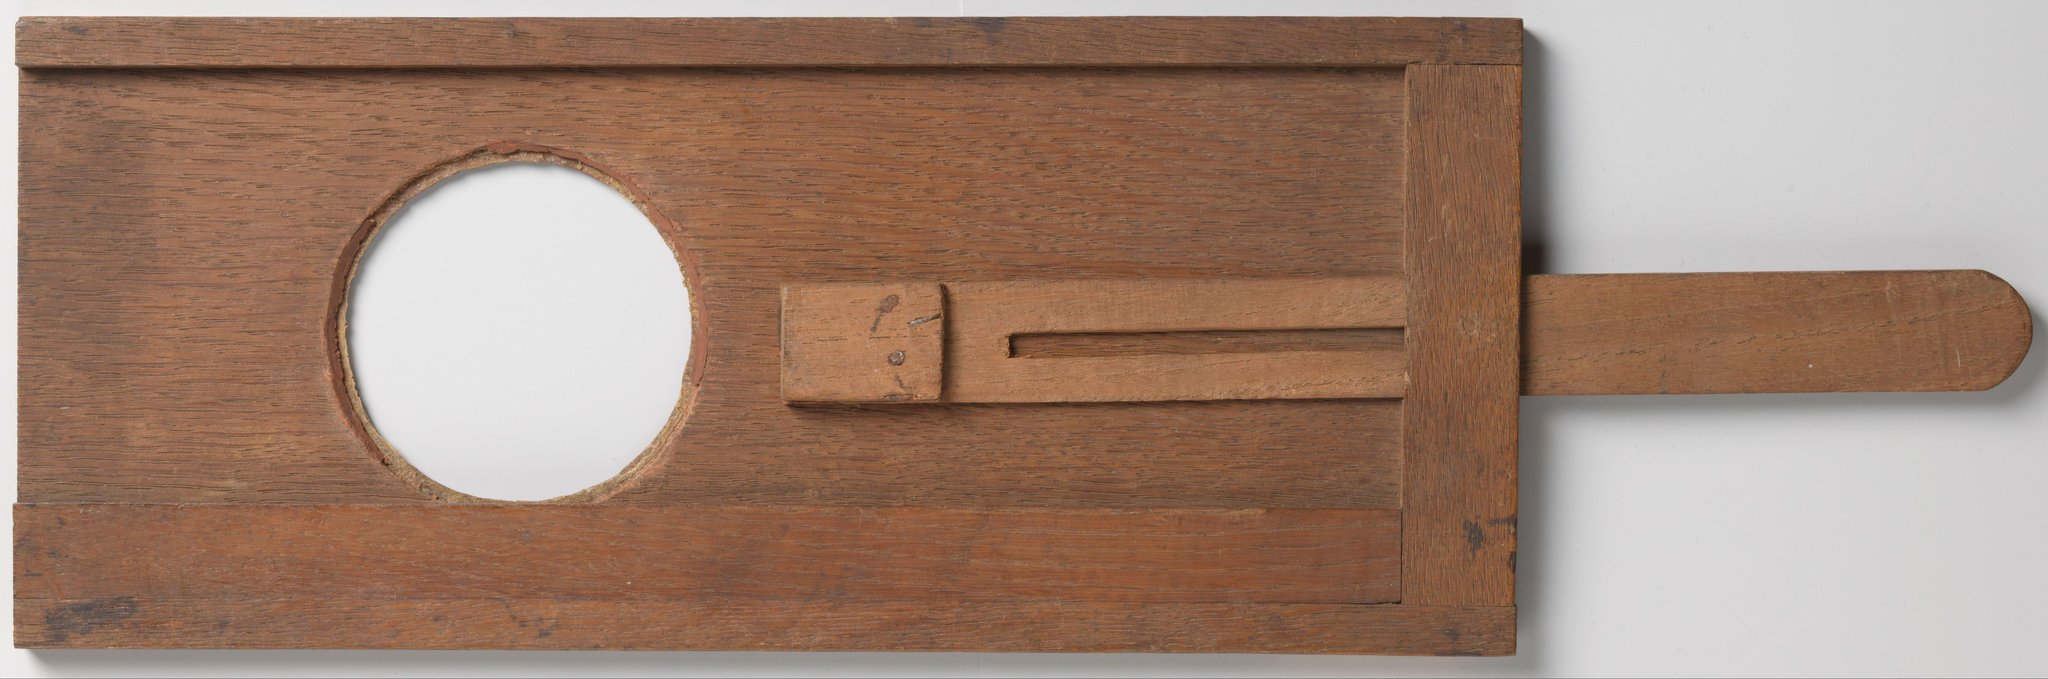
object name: lantern slide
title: Beweegbaar glas van een schip op zee en een drenkeling over boord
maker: Anonymous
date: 1700-1800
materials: glass, wood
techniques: painted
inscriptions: label: ‘'Gebrandschilderde glazen. Collectie I.S. van der Schaaff, Baarn. Nummer 62 (tweeënzestig) bevattende één glas, voorstellende een schip op zee en een drenkeling over boord, waarachter beweegbaar glas. Het glas is geheel ongeschonden en gaaf op 13 april 1886.'’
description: Houten frame zonder glasplaat, gebruikt voor toverlantaarn. Deel van vierenzestig glazen van de collectie van I.S. van der Schaaff uit Baarn. De glasplaat ontbreekt.